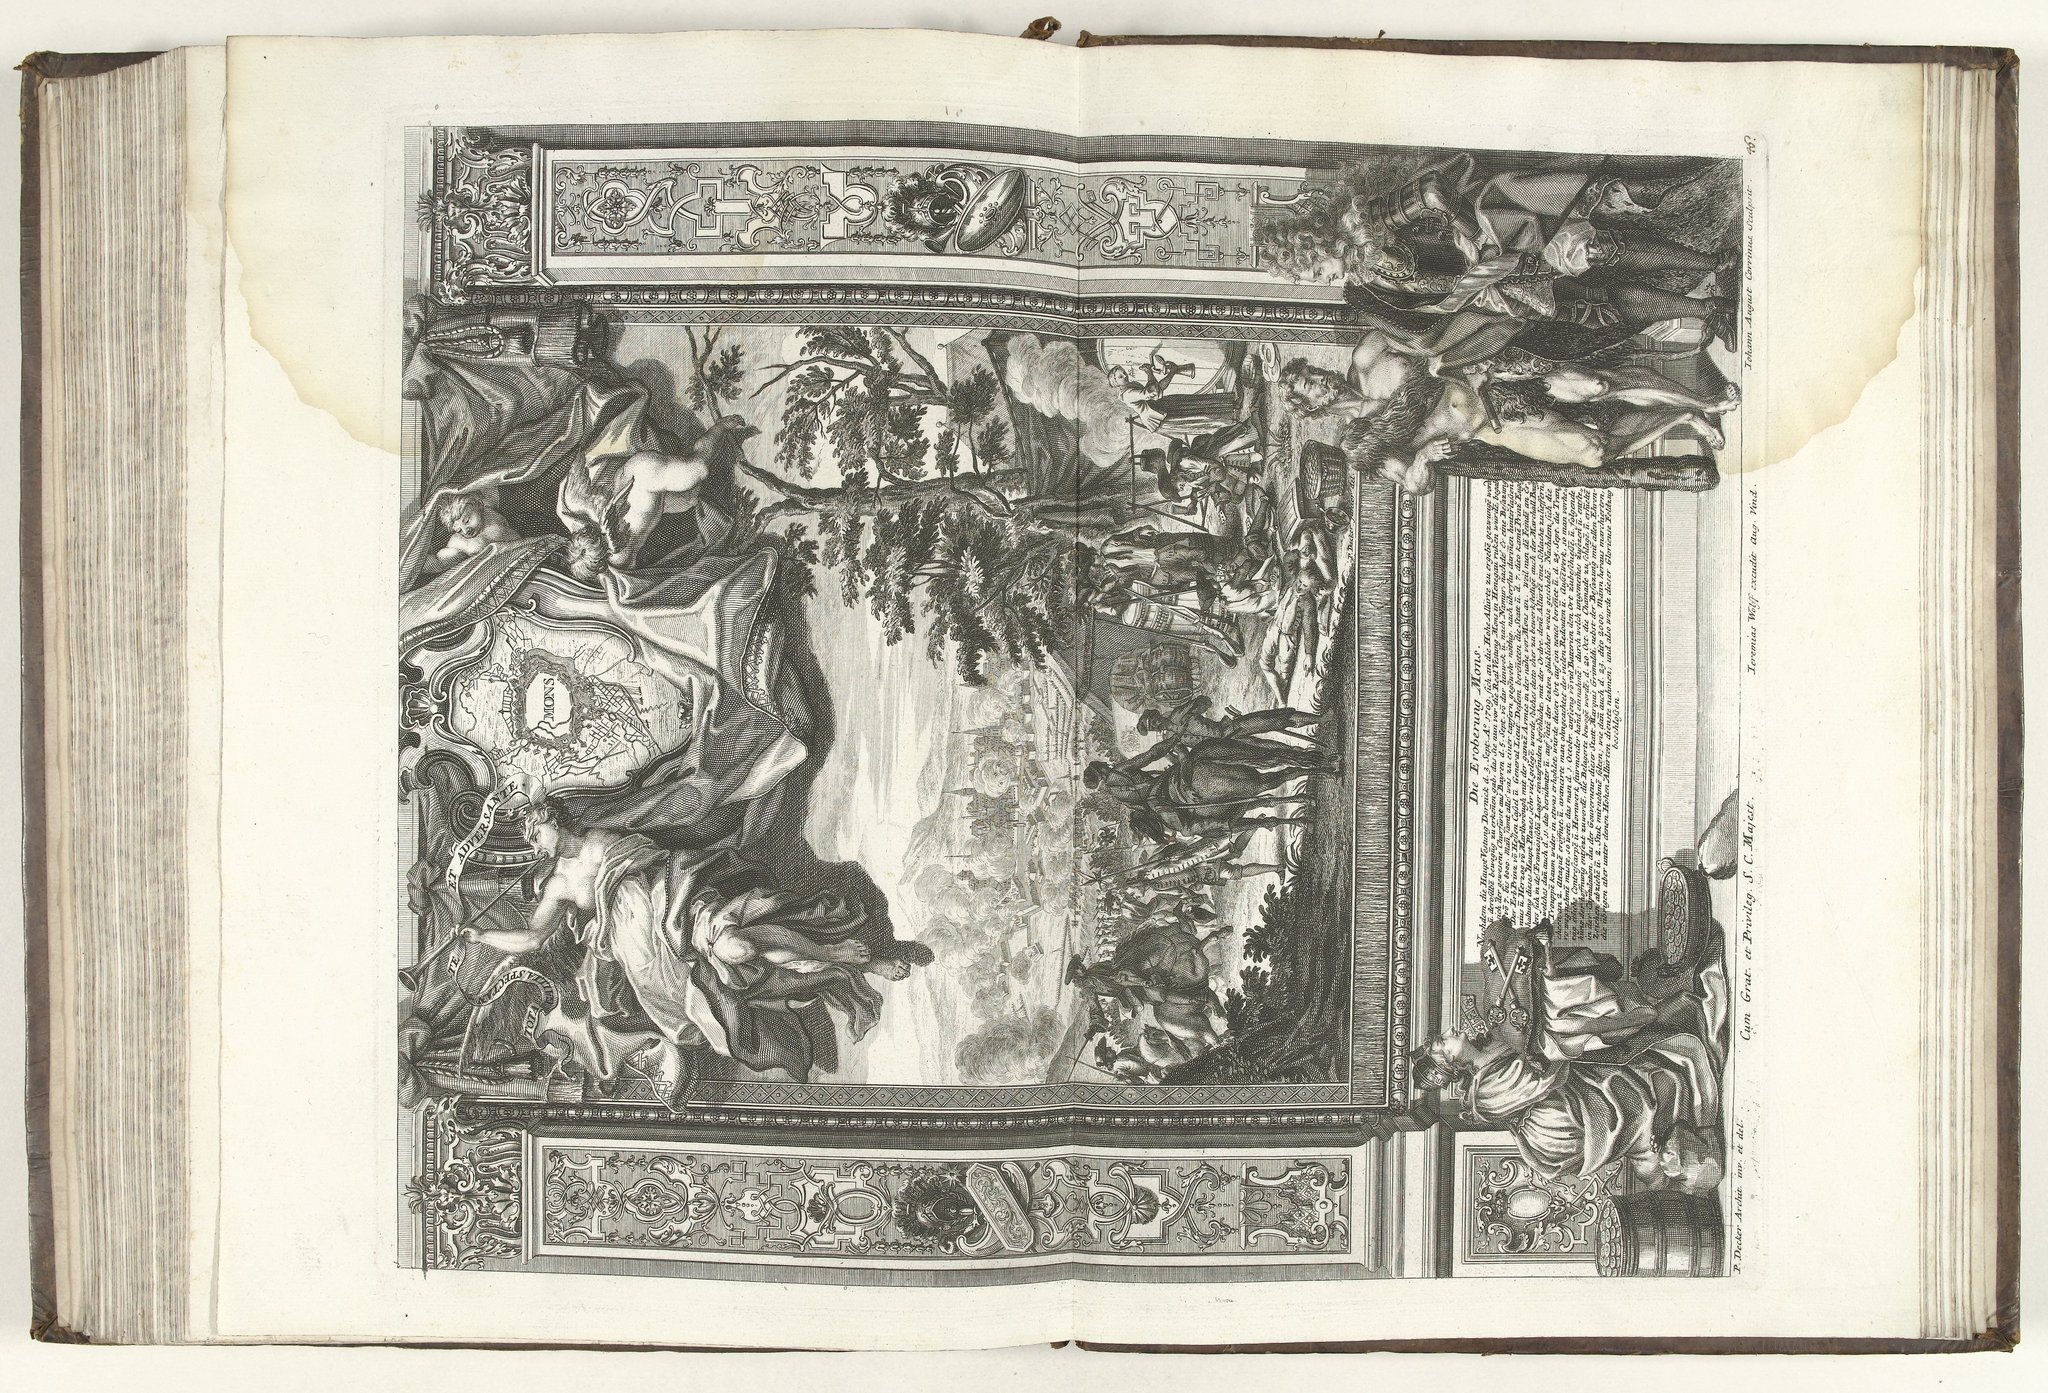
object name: history print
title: Die Eroberung Mons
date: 1712-1715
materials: paper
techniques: engraving, etching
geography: augsburg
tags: siege, position war, surrender of keys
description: Beleg en inname van Mons (Bergen) door de geallieerden, 25 september - 22 oktober 1709. De centrale voorstelling van het legerkamp van de belegeraars gevat in een rijk versierde ornamentele omlijsting. Bovenaan een cartouche met een plattegrond van de stad en Faam met een bazuin. Onderaan links de aanbieding door de stadsmaagd van de sleutels van de stad en zakken met geldstukken aan de jonge vorst die rechts staat naast Hercules. In het midden een cartouche met de beschrijving van de gebeurtenissen in het Duits. Blad in de gebonden verzameling platen uitgebracht onder de titel: Repraesentatio belli ... Der Spanische Successions-Krieg [ca. 1720].